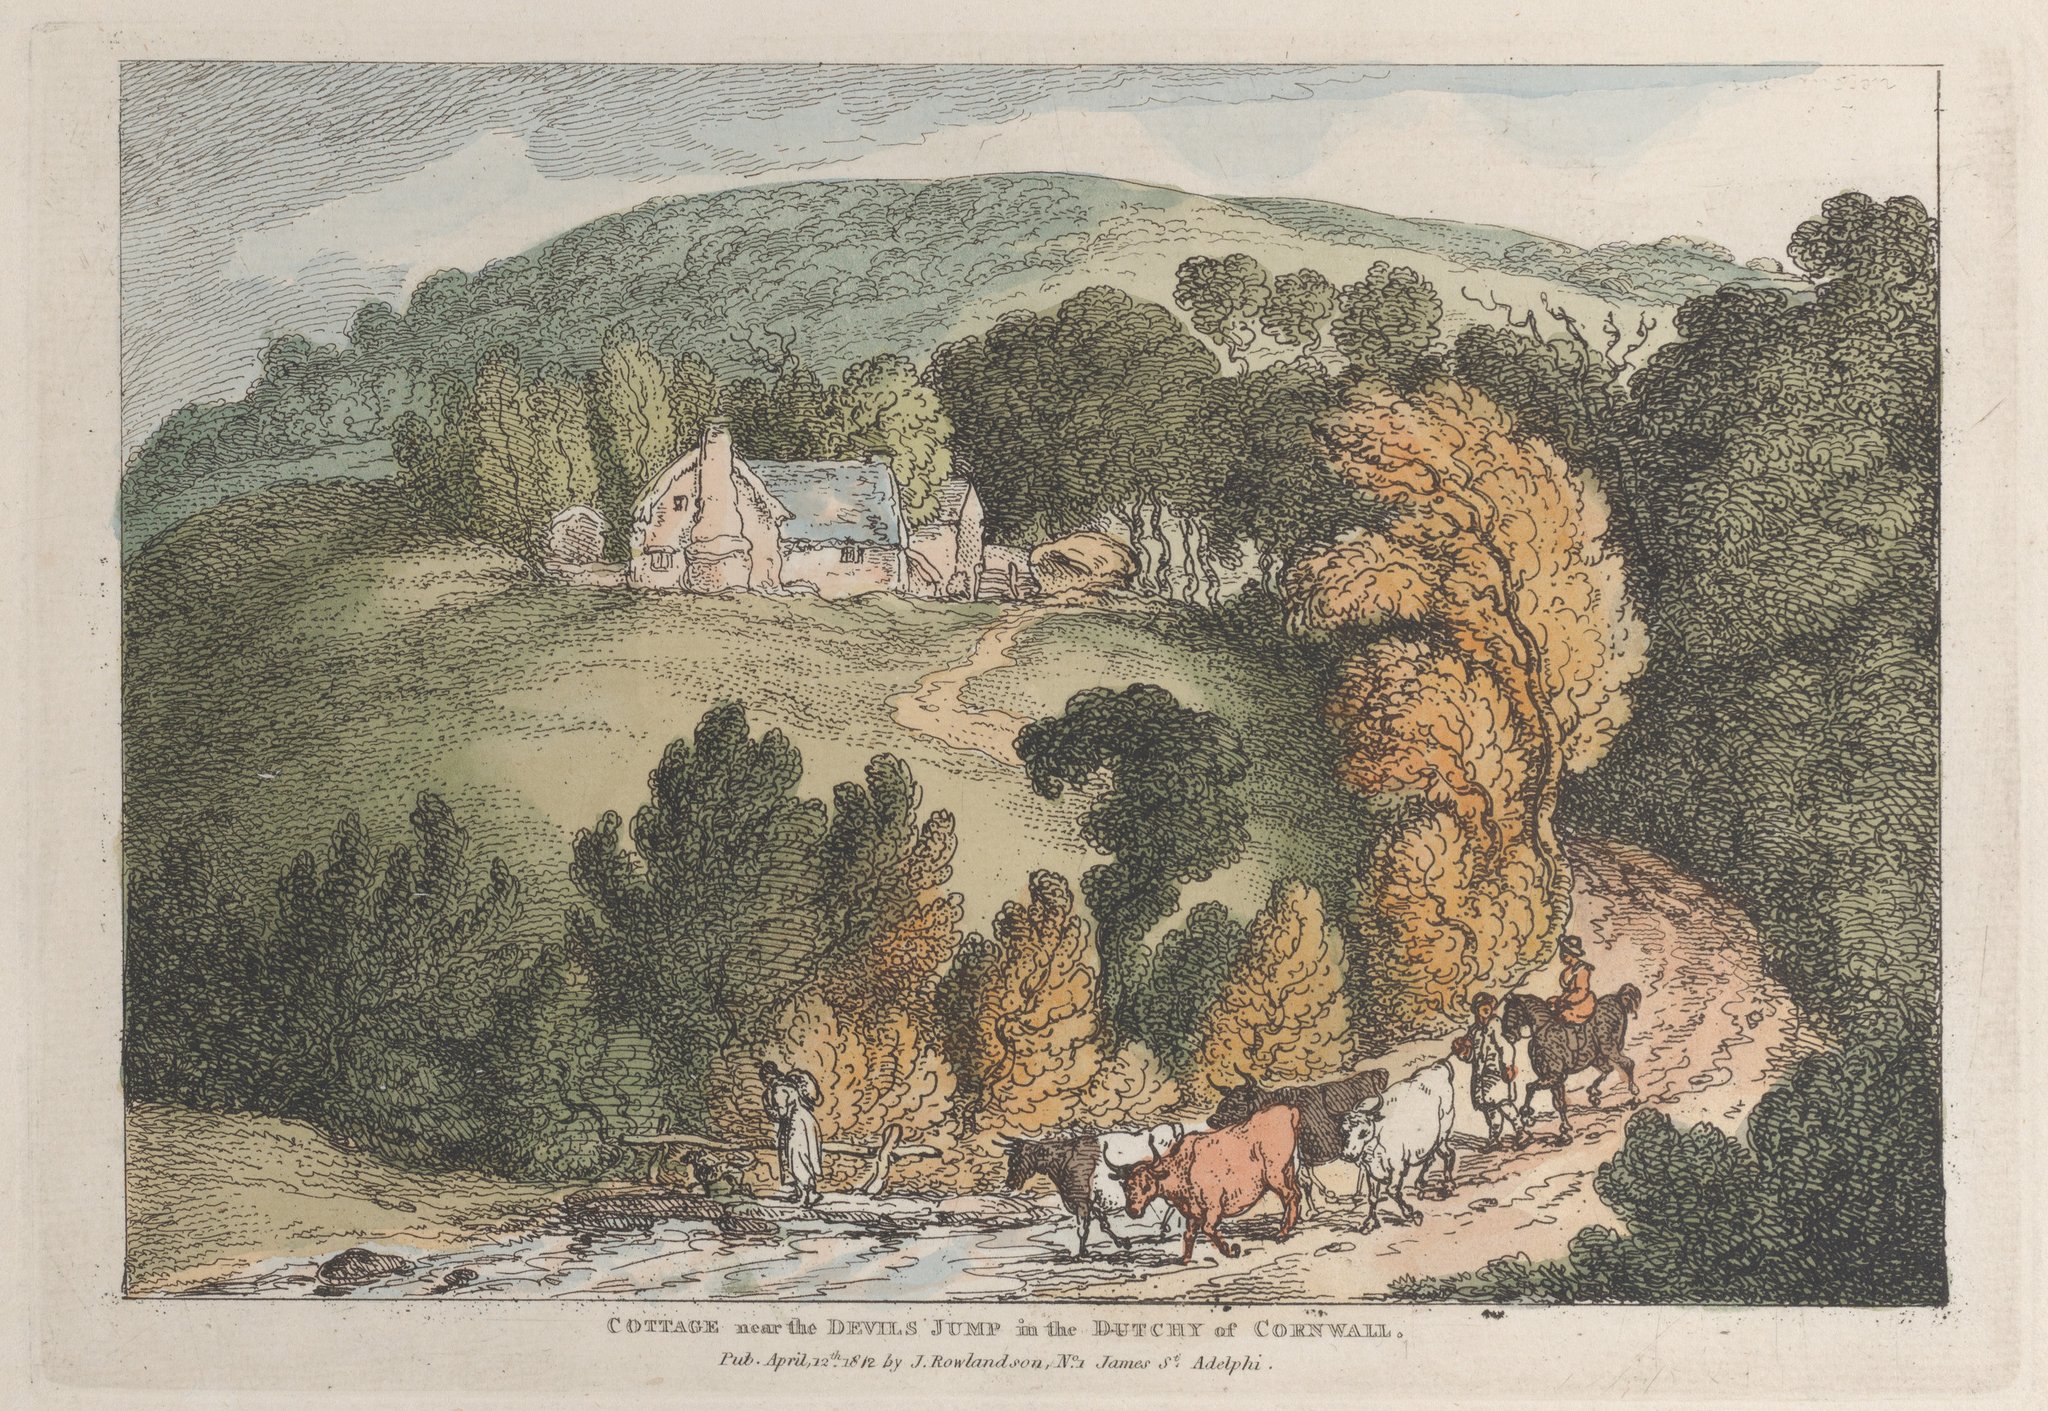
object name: print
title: View of the Church and Village of St. Cue, Cornwall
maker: thomas rowlandson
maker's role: artist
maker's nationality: british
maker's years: 1757-1827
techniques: etching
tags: landscapes